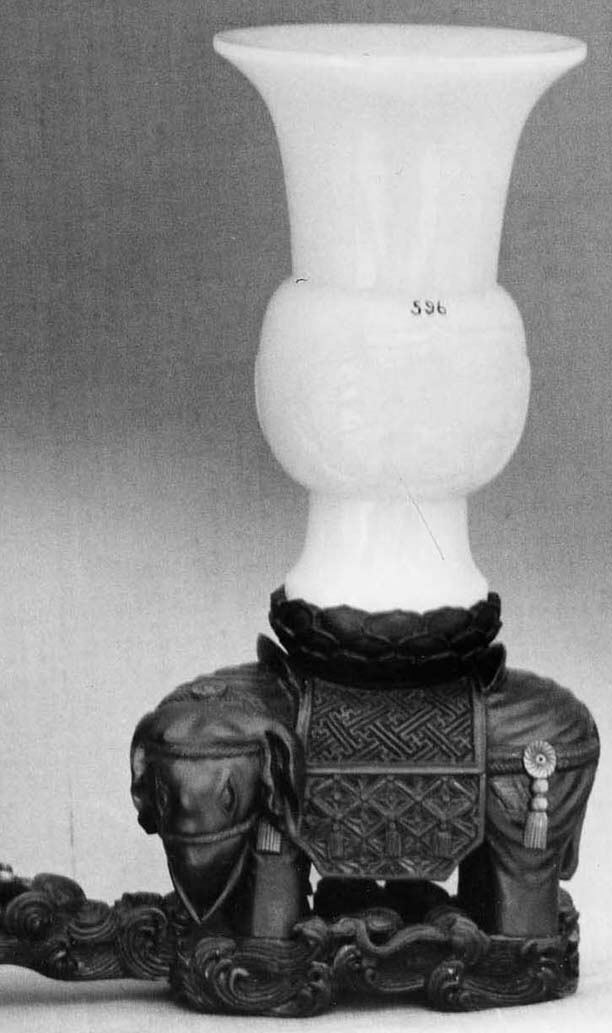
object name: vase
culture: chinese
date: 1701-1800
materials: jade